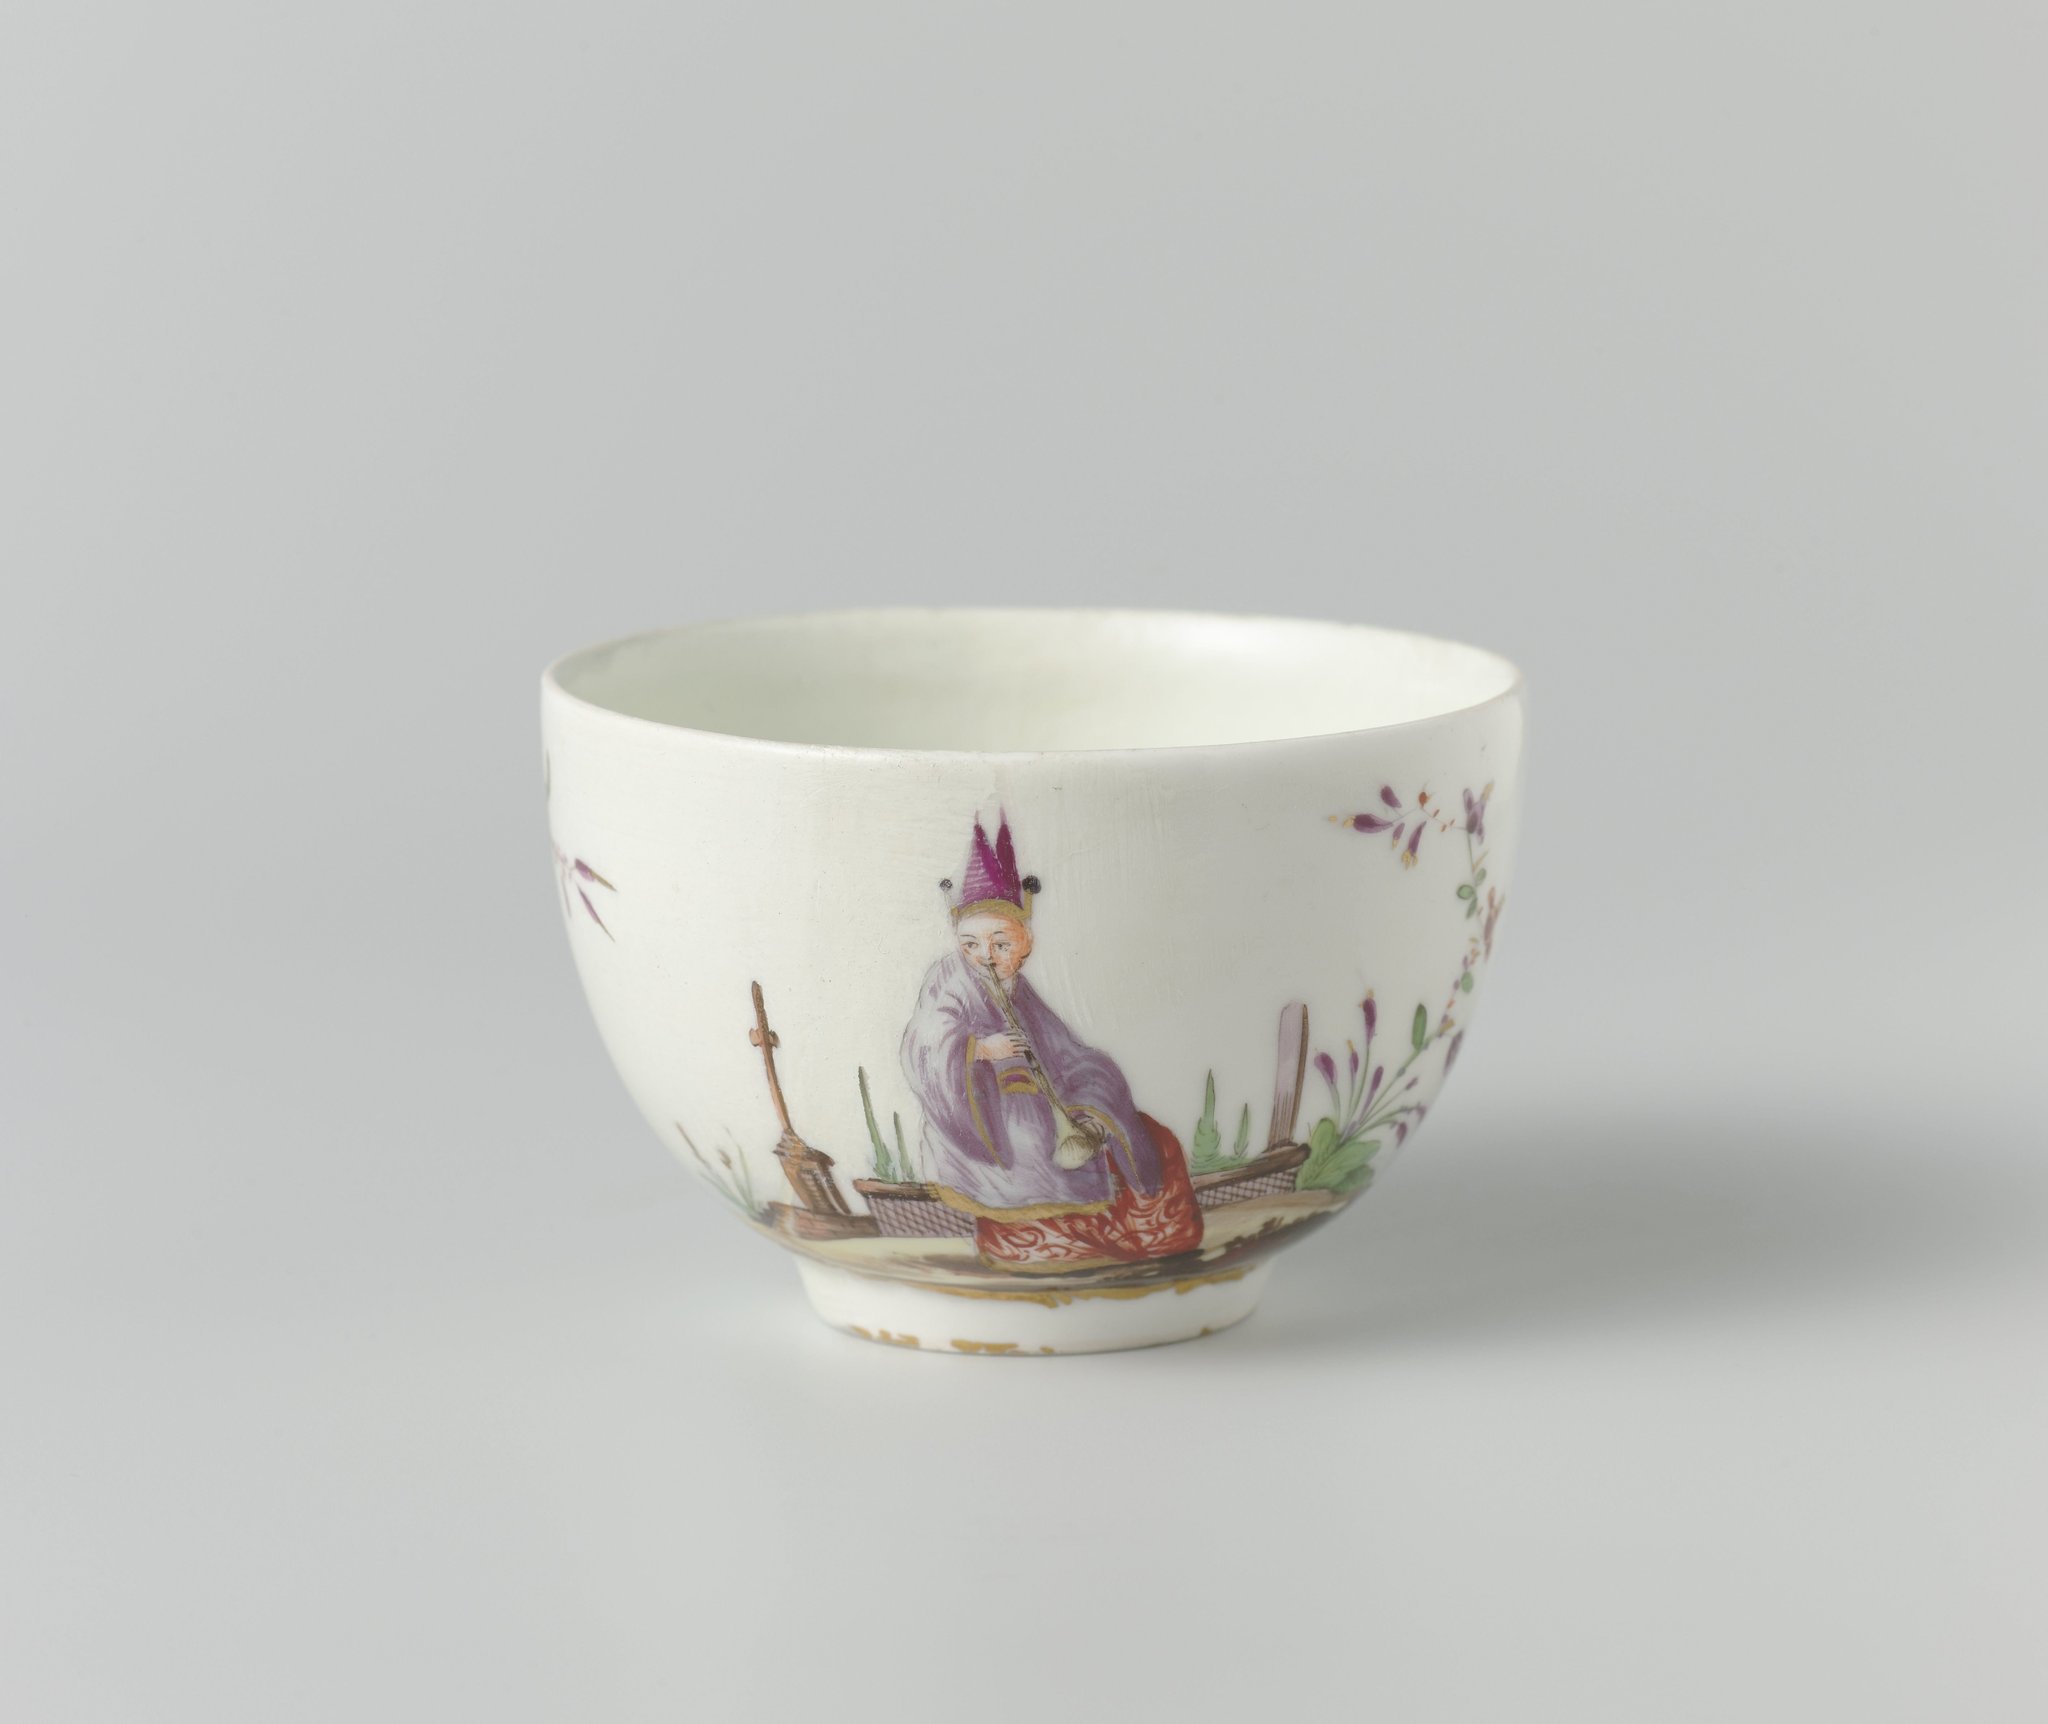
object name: cup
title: Kop zonder oor, veelkleurig beschilderd met chinoiserieën en losse bloemtakken langs de randen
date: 1765-1770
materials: porcelain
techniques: painted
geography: weesp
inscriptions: mark: ‘wapen weesp’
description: Kop, veelkleurig beschilderd met chinoiserieën en losse bloemtakjes langs de randen. Gemerkt met twee gekruiste zwaarden en drie bollen in onderglazuurblauw.